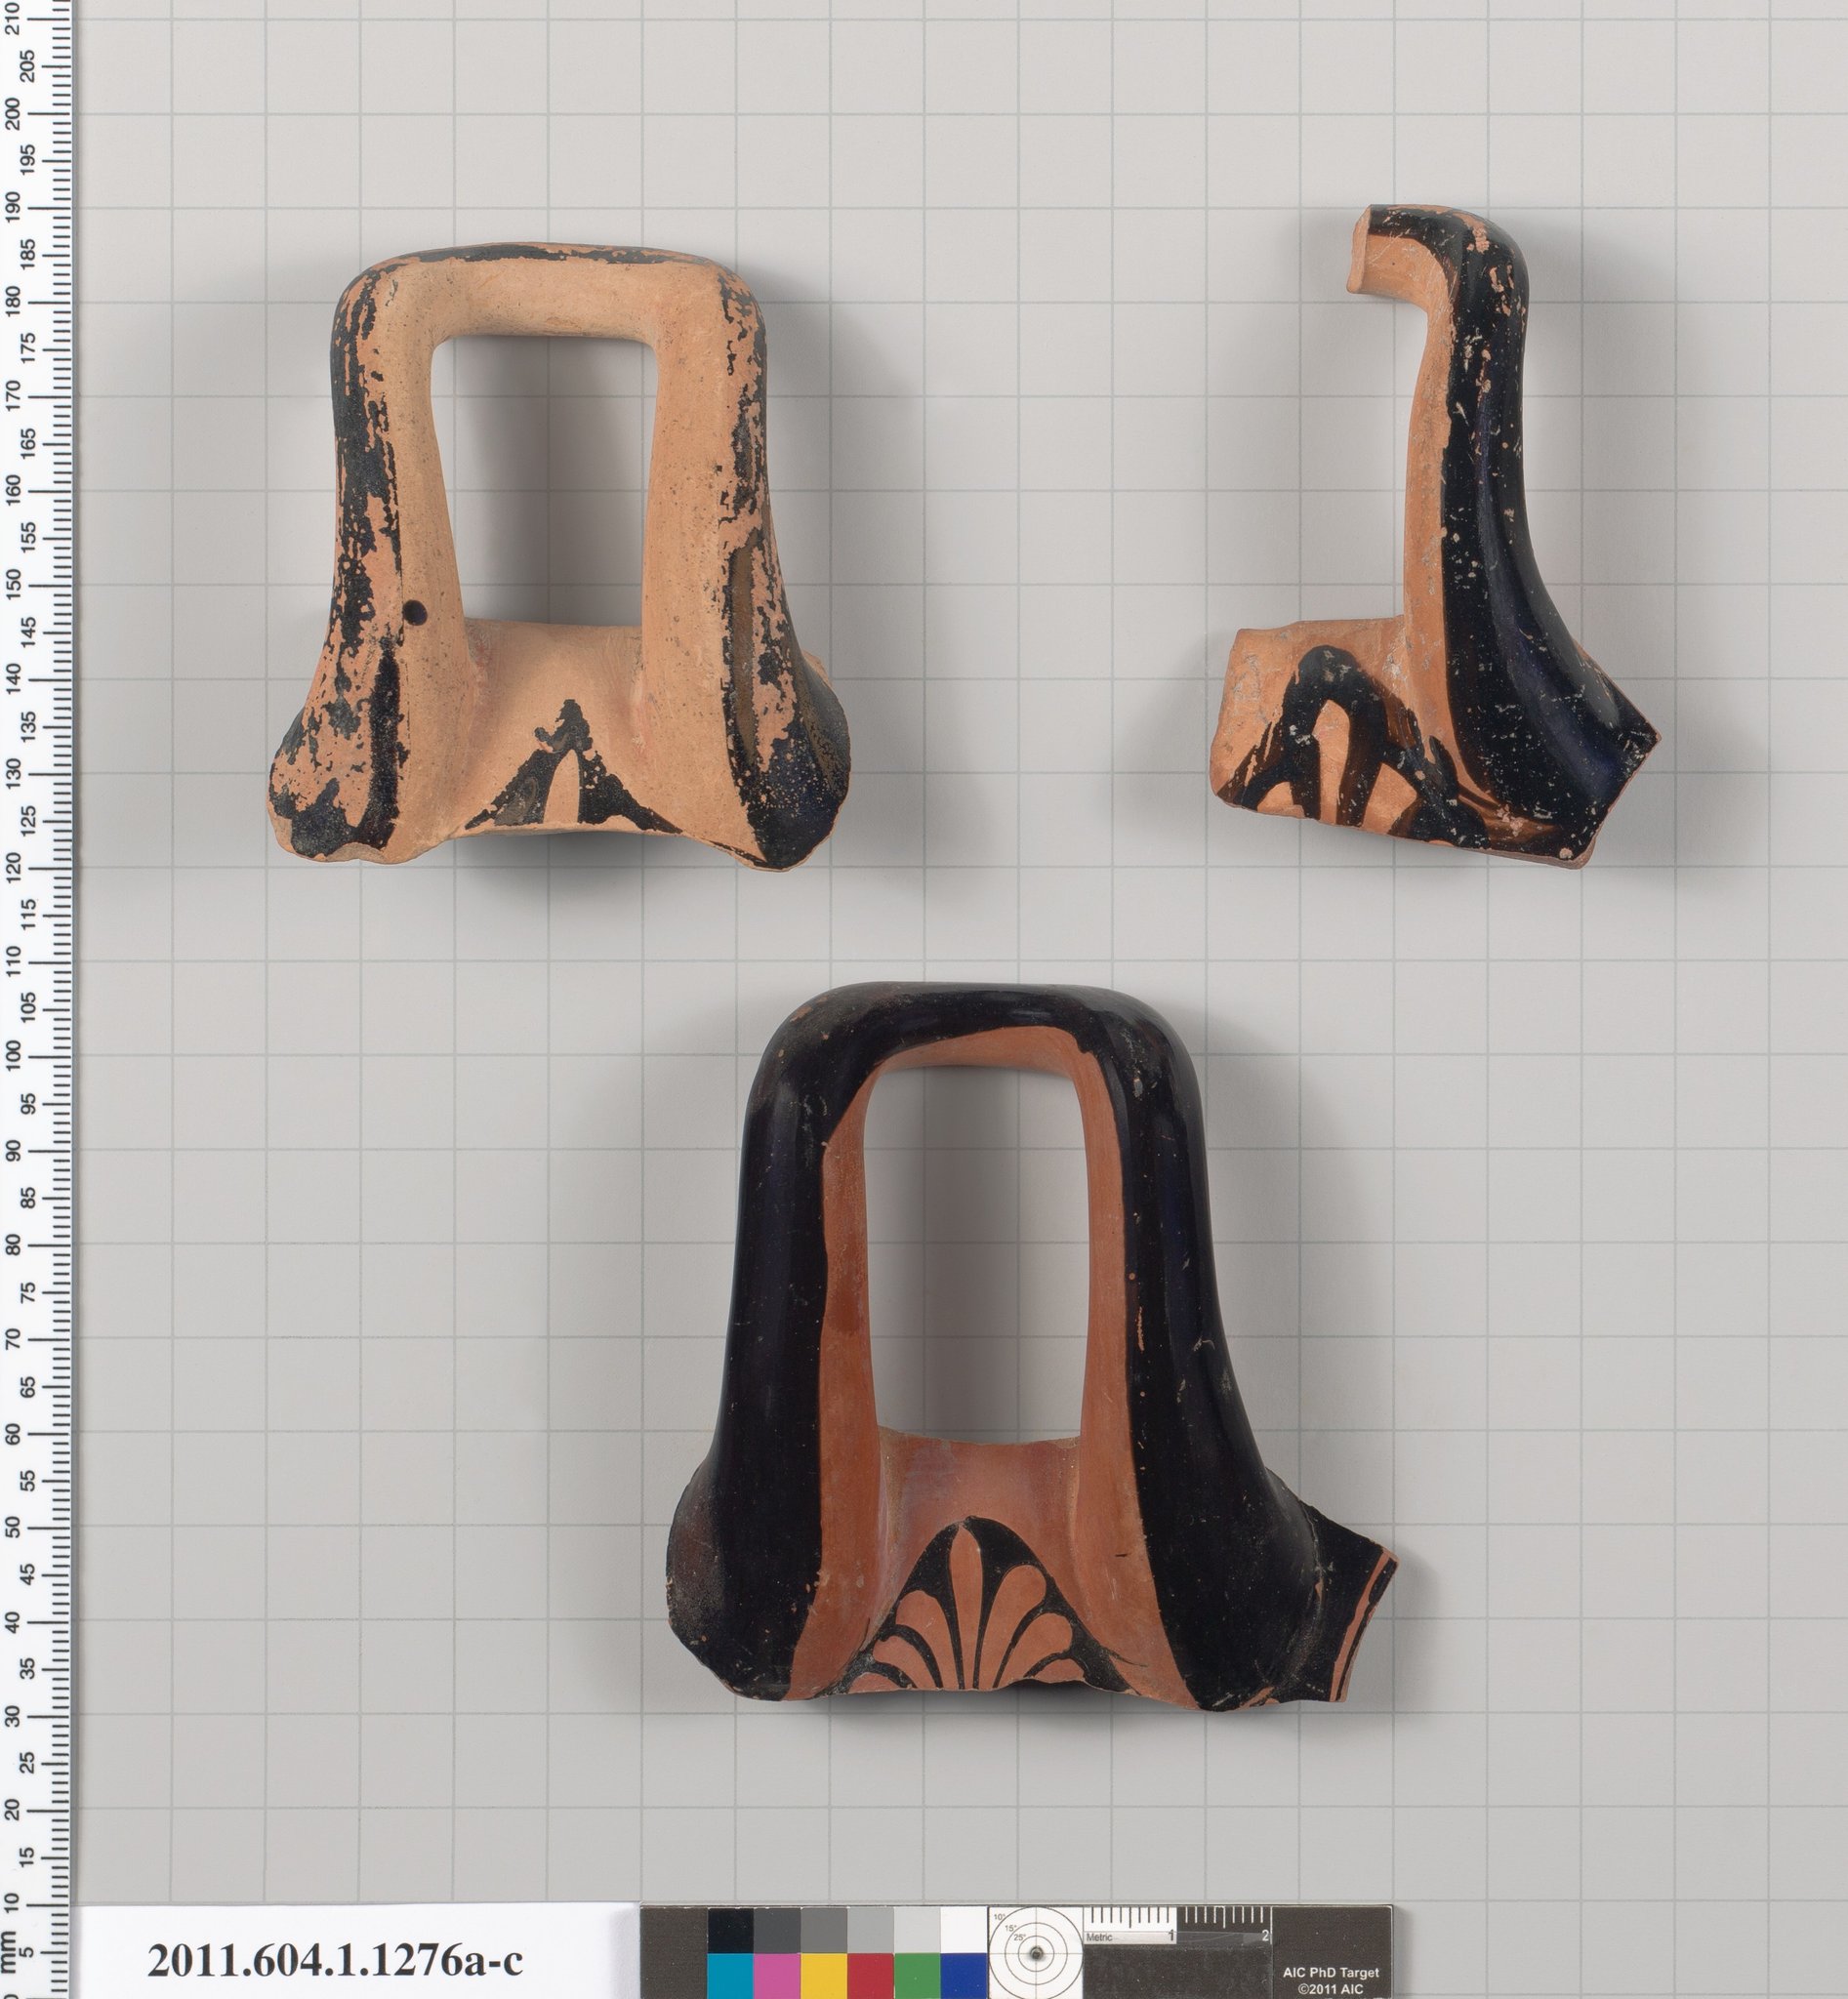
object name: kylix fragment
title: Terracotta fragments of kylikes (drinking cups)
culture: greek, attic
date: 500-401 BCE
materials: terracotta